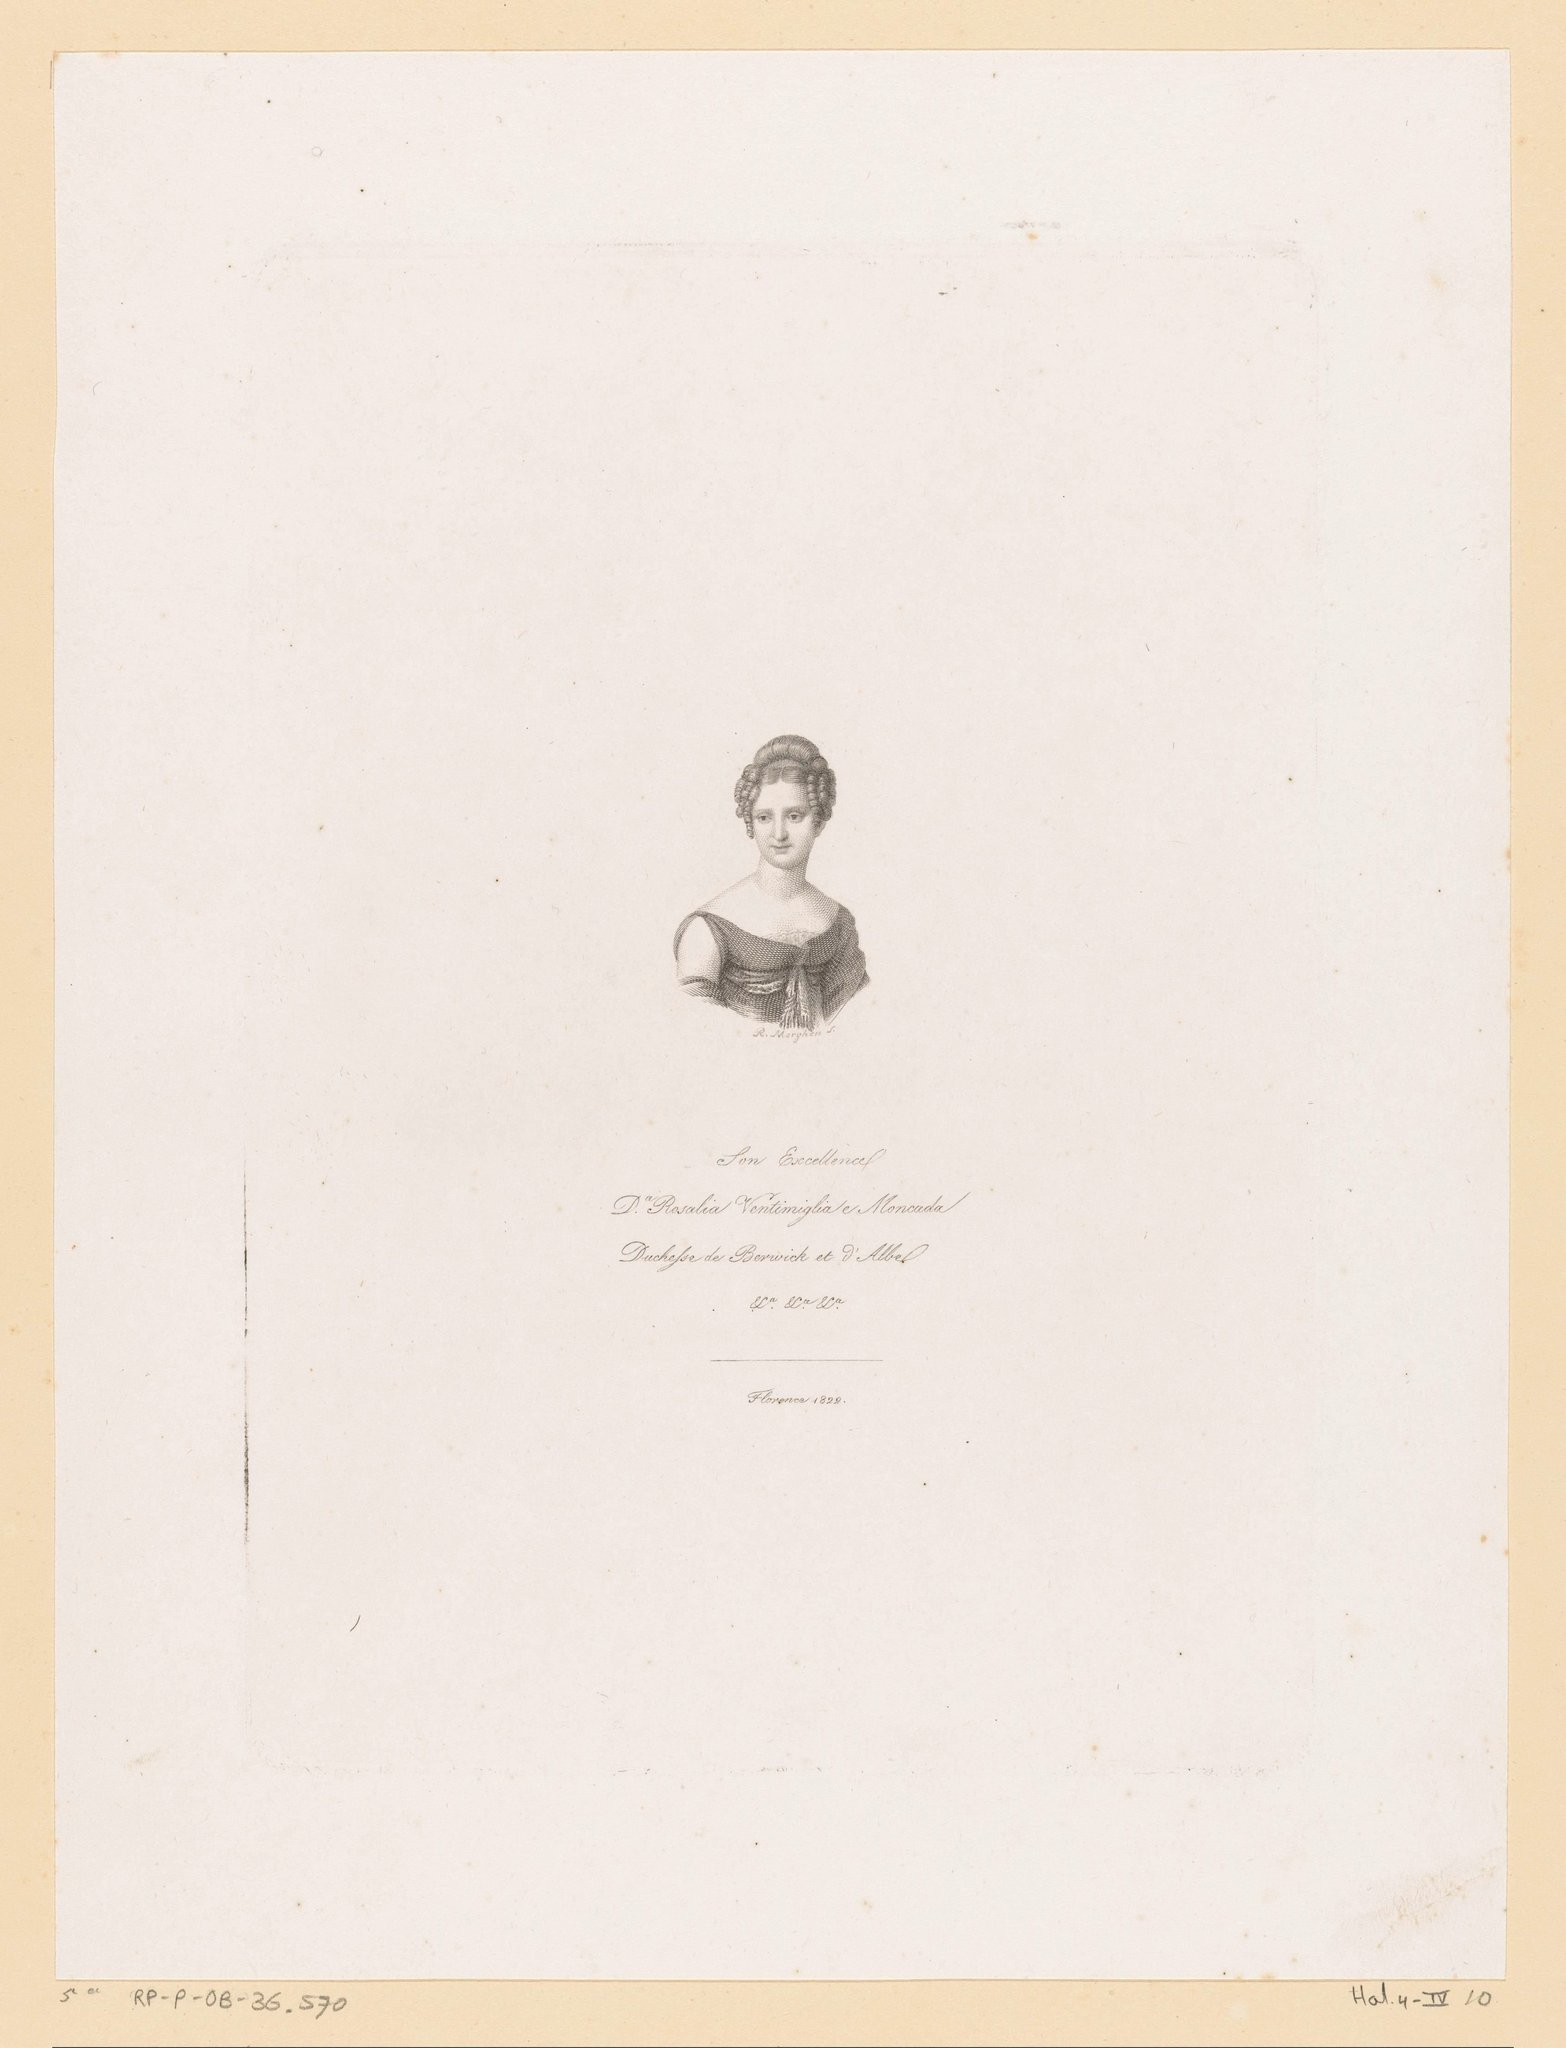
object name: print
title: Portret van Rosalia Vintimiglia, hertogin van Berwick en Alba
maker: raphael morghen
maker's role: draughtsman, painter, print maker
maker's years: 1758-1833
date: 1822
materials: paper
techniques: engraving, etching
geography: florence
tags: historical persons, ruler, sovereign - bb - female ruler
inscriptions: collector's mark: Lugt 12